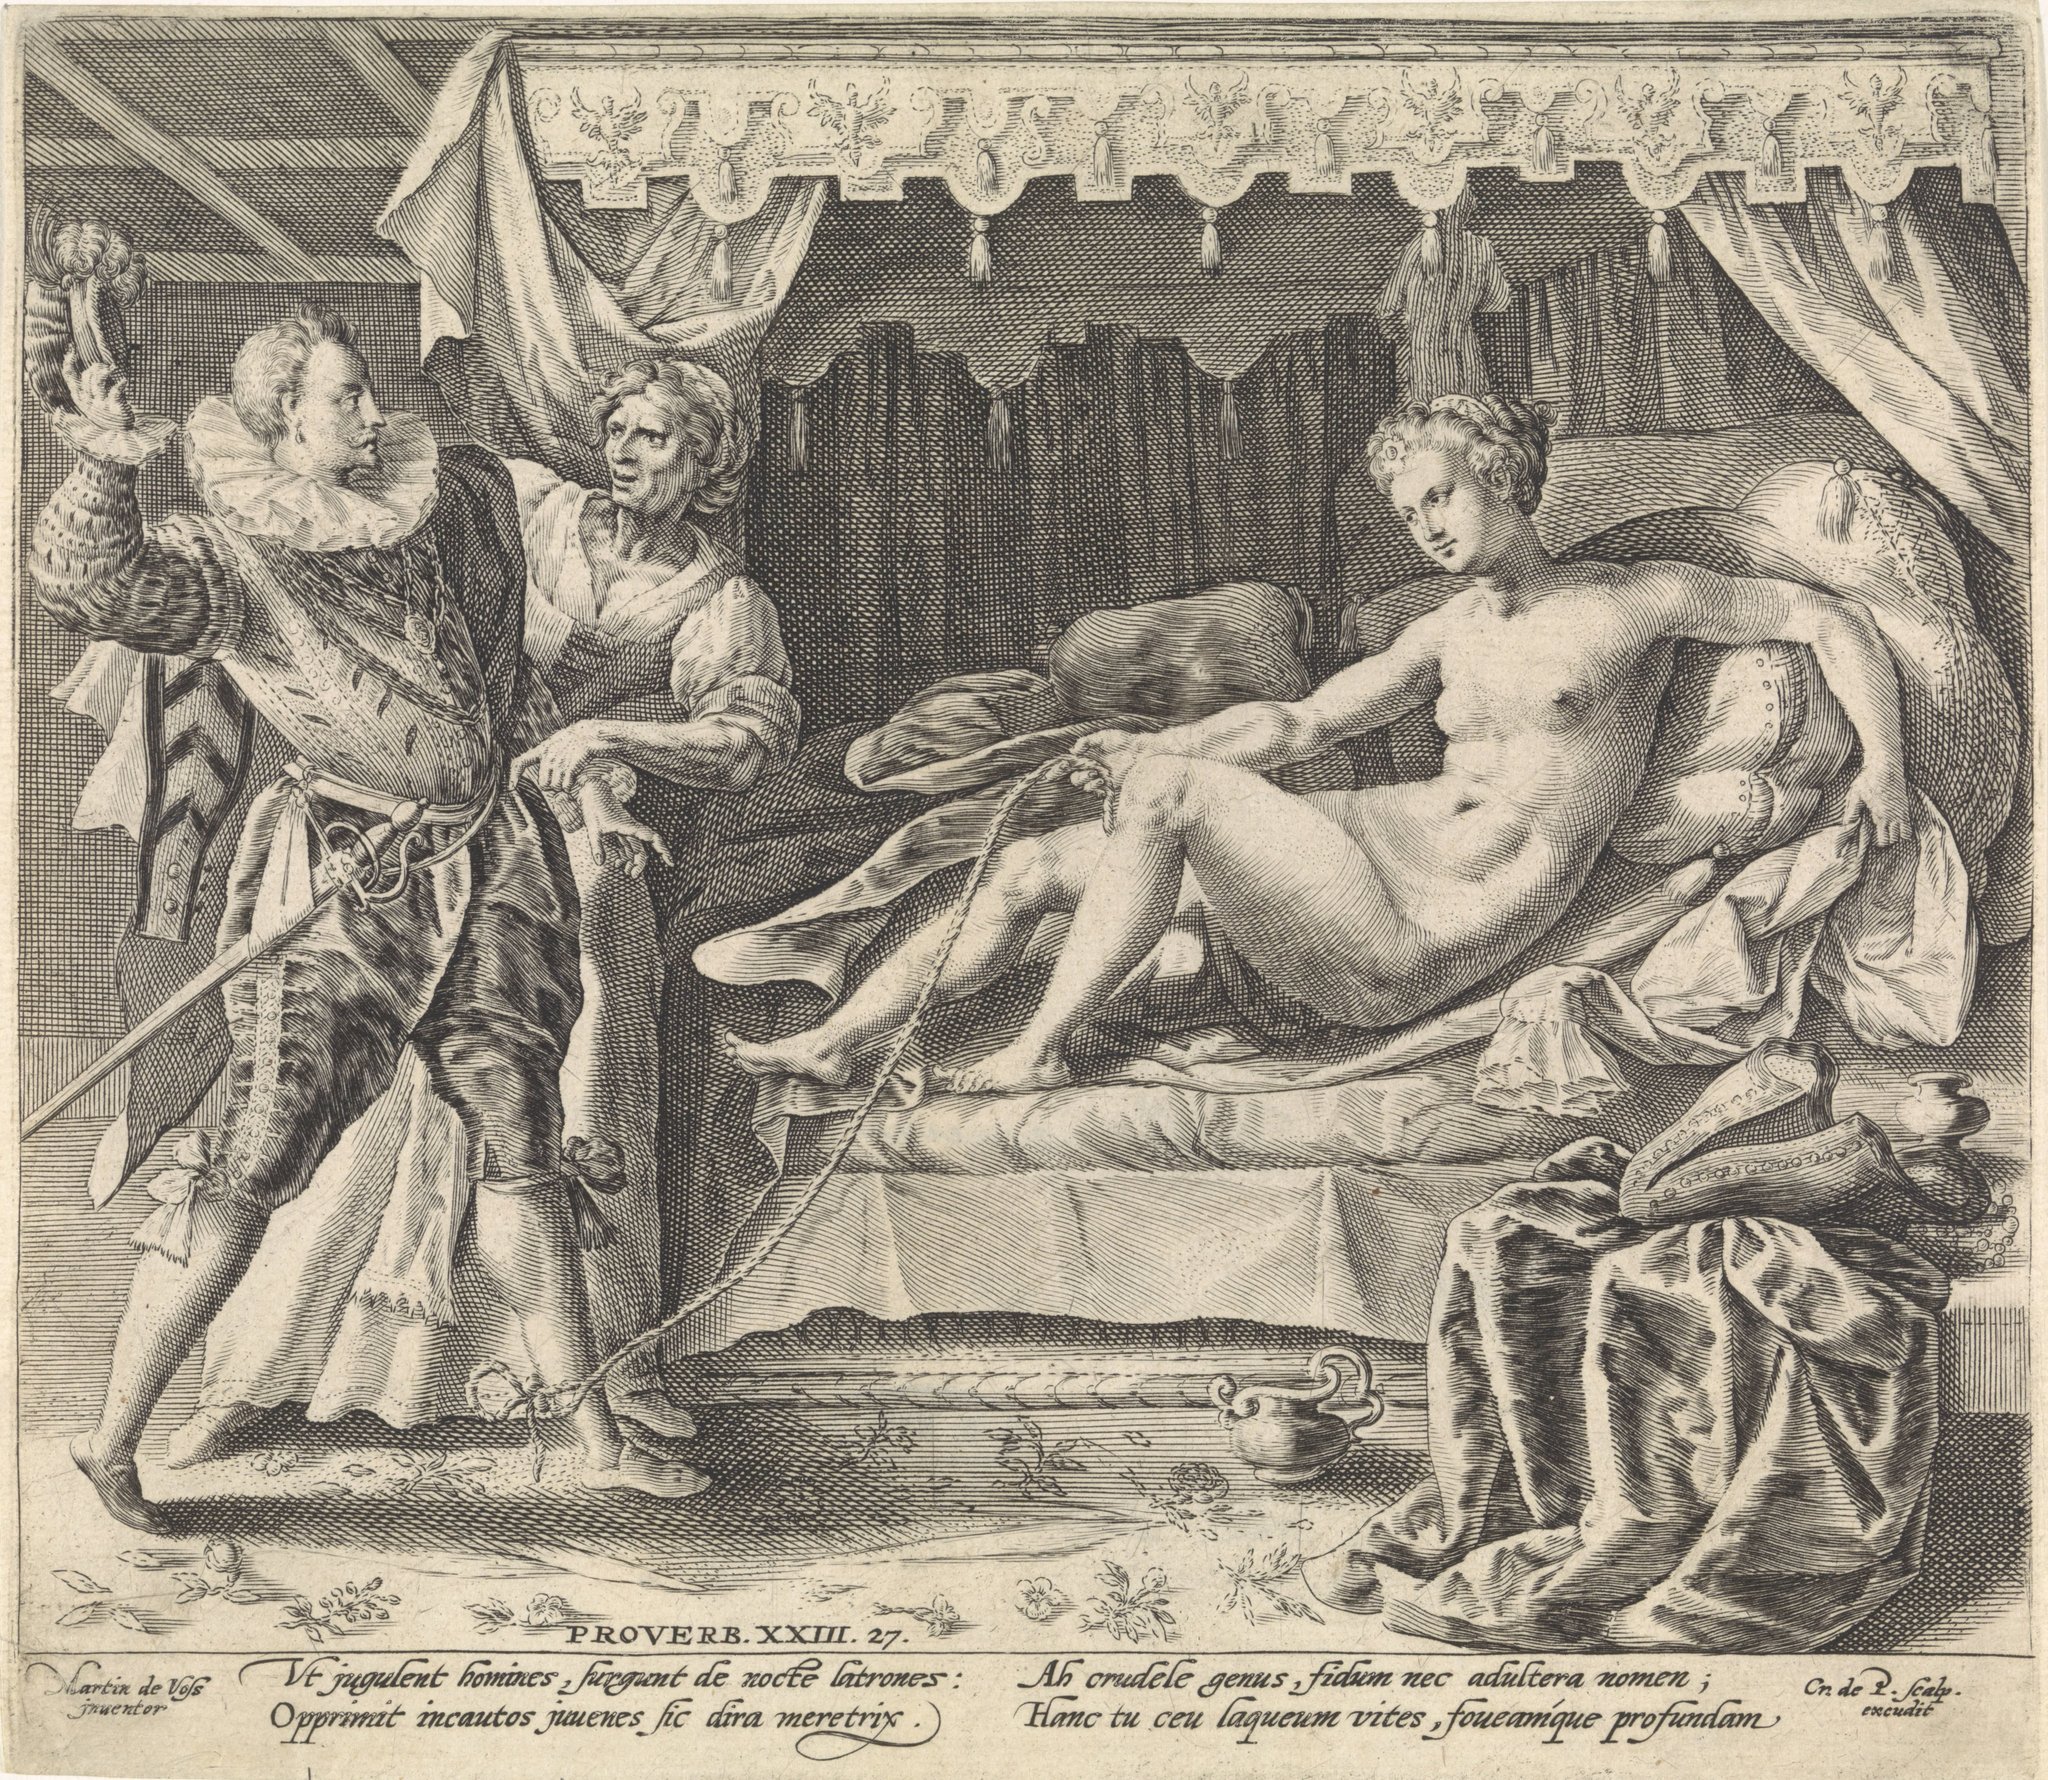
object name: print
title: Man Visiting a Prostitute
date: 1580-1588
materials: paper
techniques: engraving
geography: antwerp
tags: the book of proverbs (with book chapter:verse)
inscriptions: collector's mark: Lugt 2228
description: This print illustrates a line from the Book of Proverbs in the Hebrew Bible: ‘Because a prostitute is a deep pit, and the adulterous woman a narrow well’. This noble gentleman is about to fall into the trap, lured by the elderly woman, possibly the procuress, to this prostitute’s bed. The fate that awaits him is symbolized by the rope she has tied to his ankle.